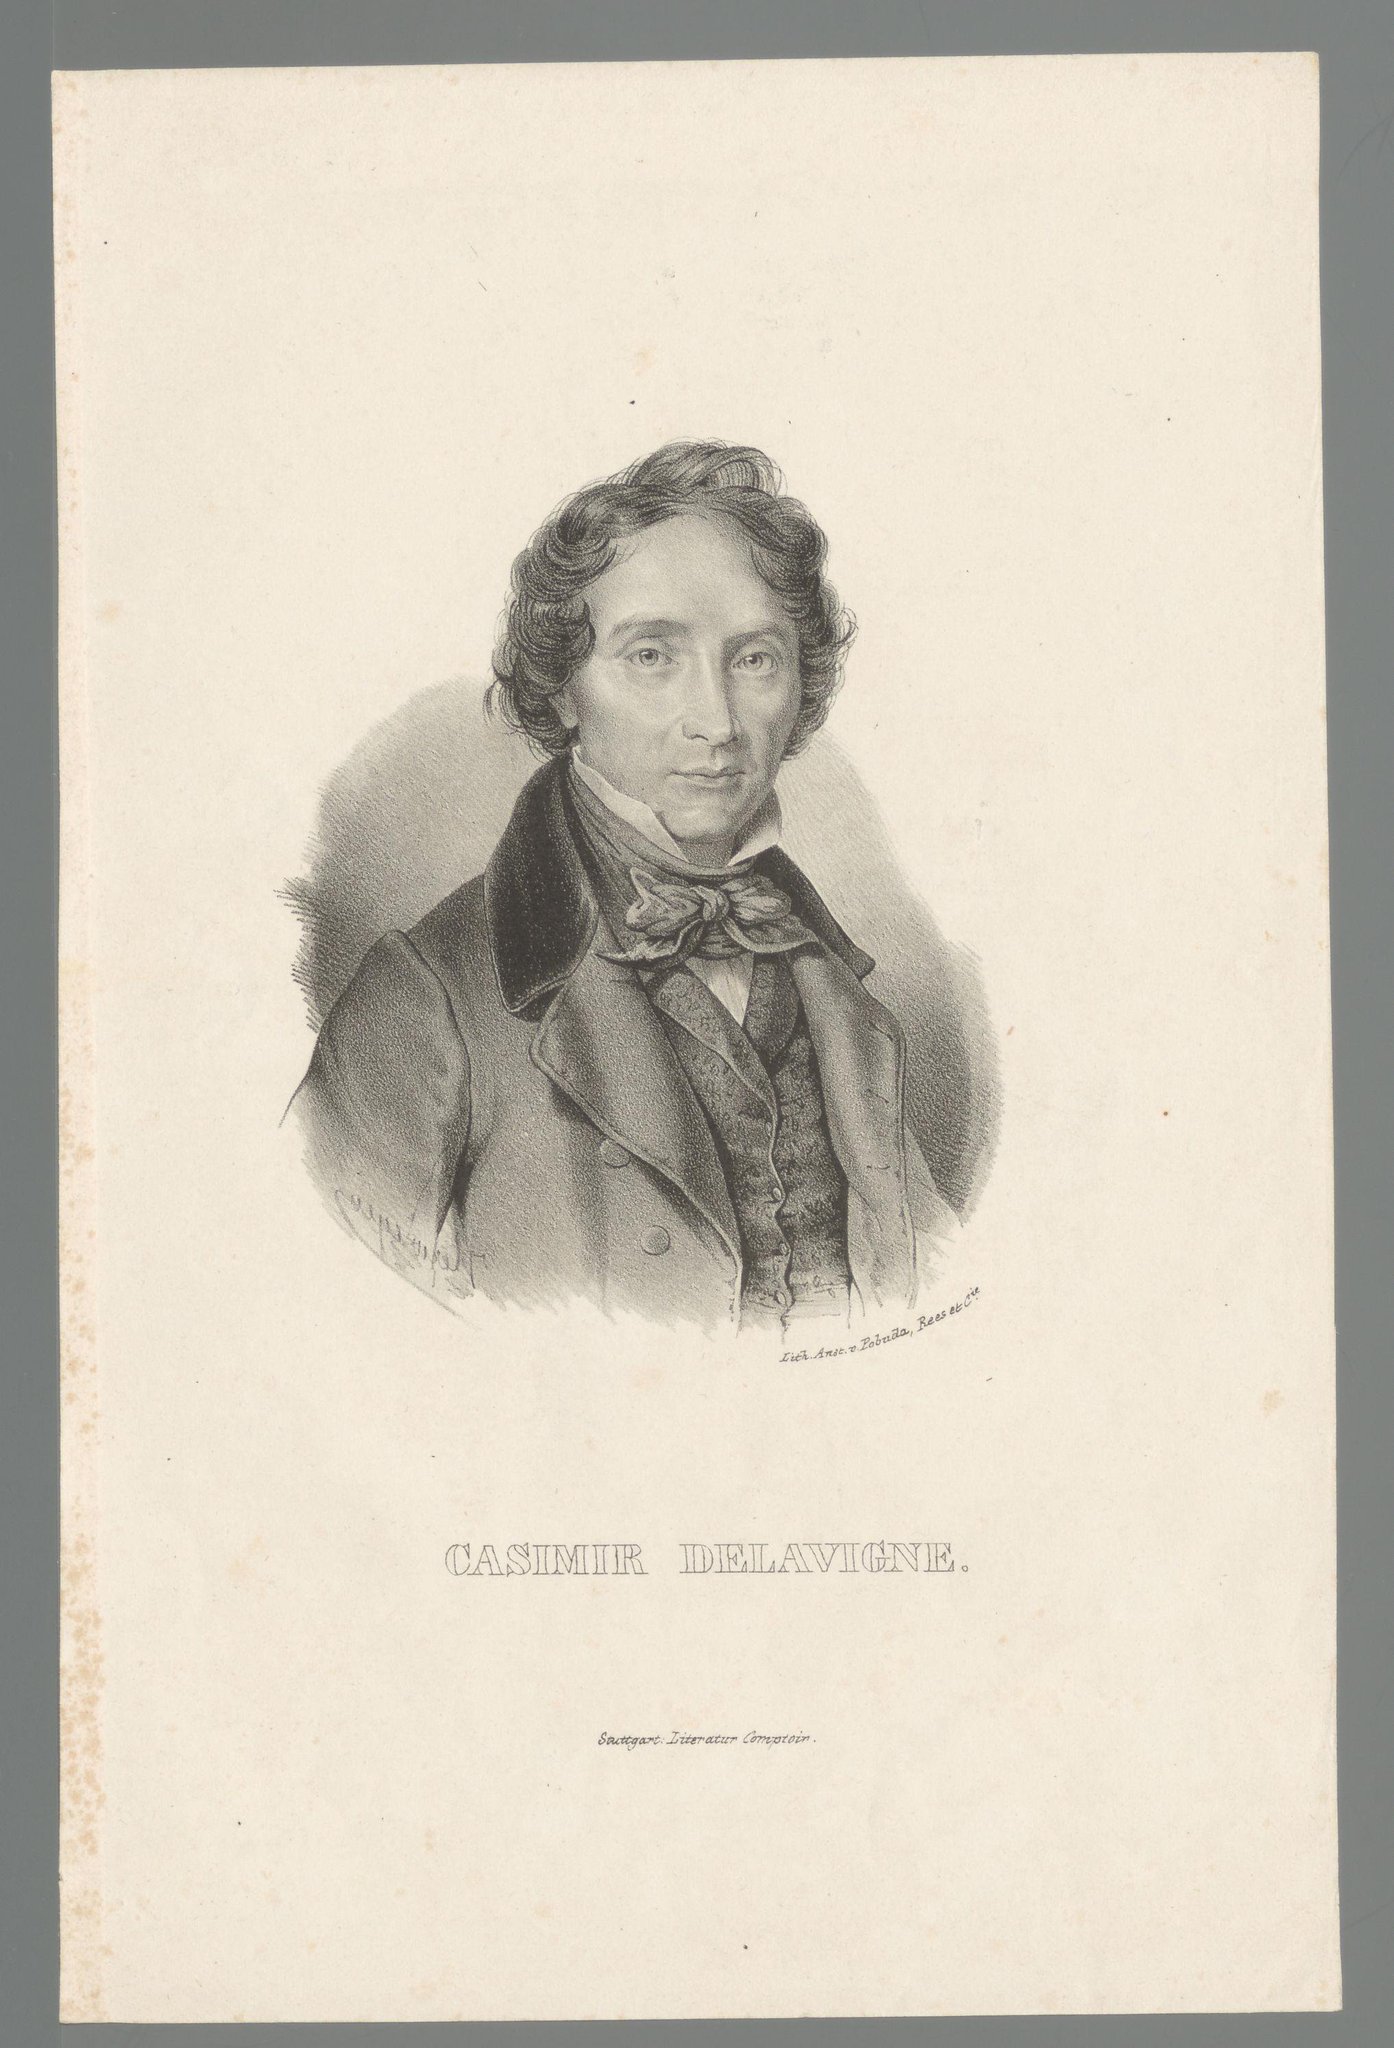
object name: print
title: Casimir Delavigne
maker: peter herwegen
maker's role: print maker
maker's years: 1814-1893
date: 1824-1893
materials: paper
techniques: lithograph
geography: stuttgart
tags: historical persons, portrait of a writer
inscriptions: collector's mark: Lugt 2228